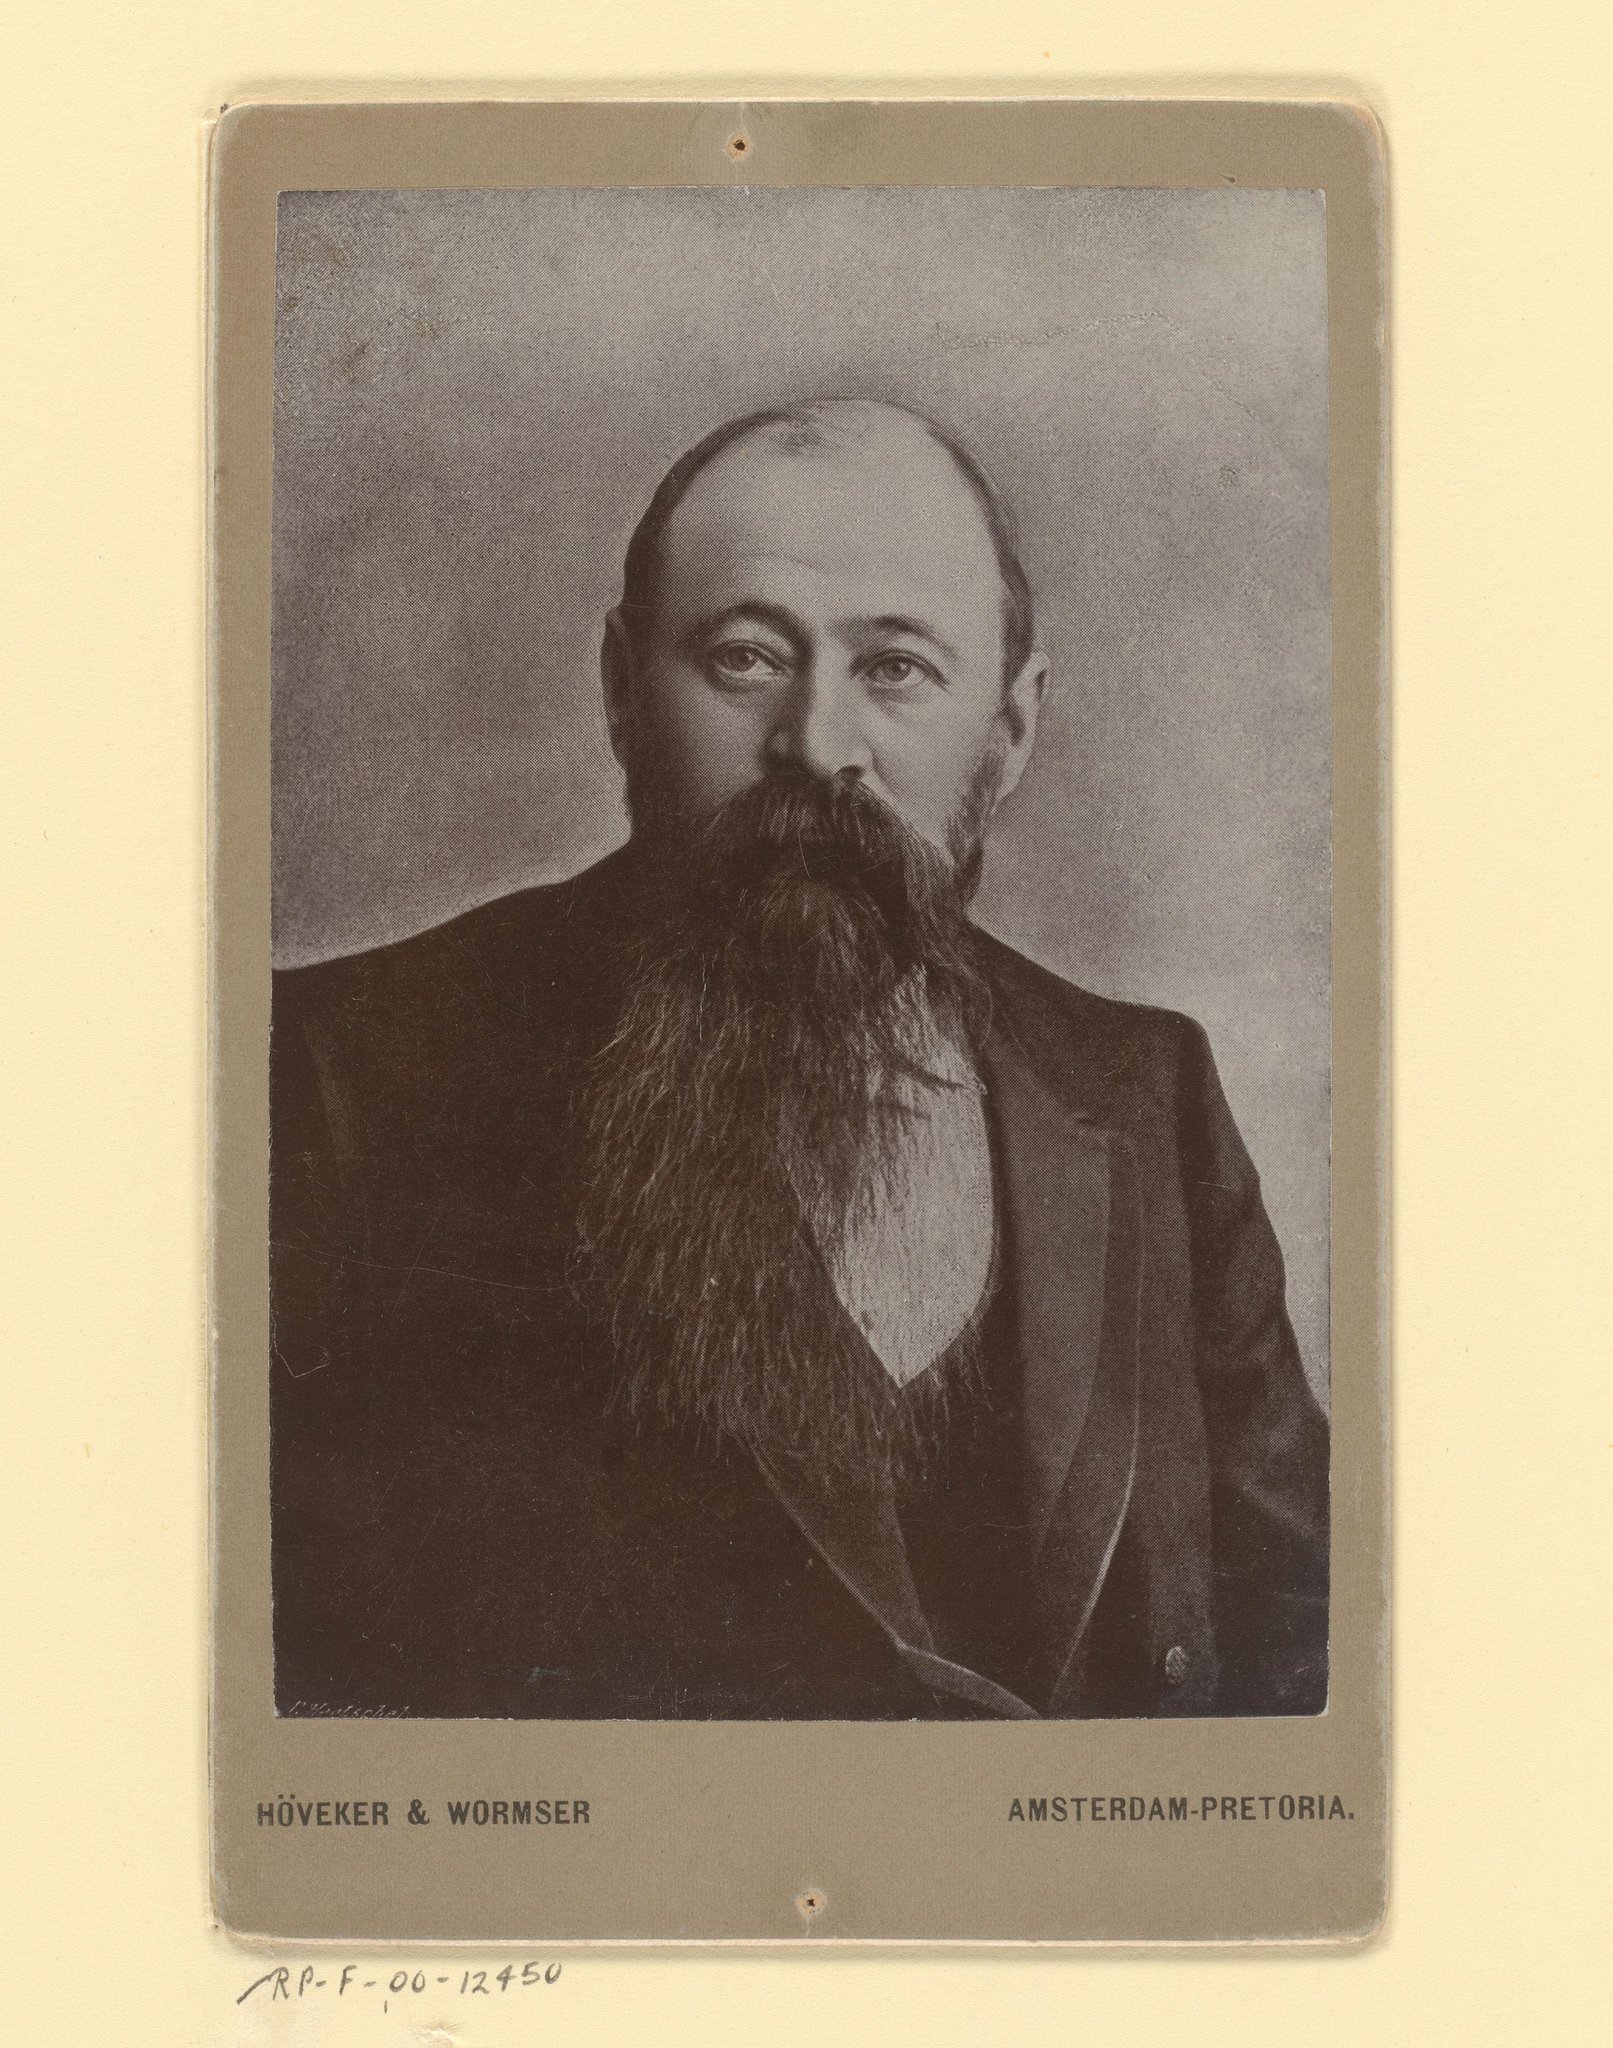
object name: cabinet photograph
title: Fotoreproductie van een autotypie van een portret van Louis Botha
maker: Anonymous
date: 1900-1919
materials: paper, cardboard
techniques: collodion silver print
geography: amsterdam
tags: prime minister, historical persons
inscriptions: name: ‘C. Henlschel [?]’, inscription: ‘50/ Botha’